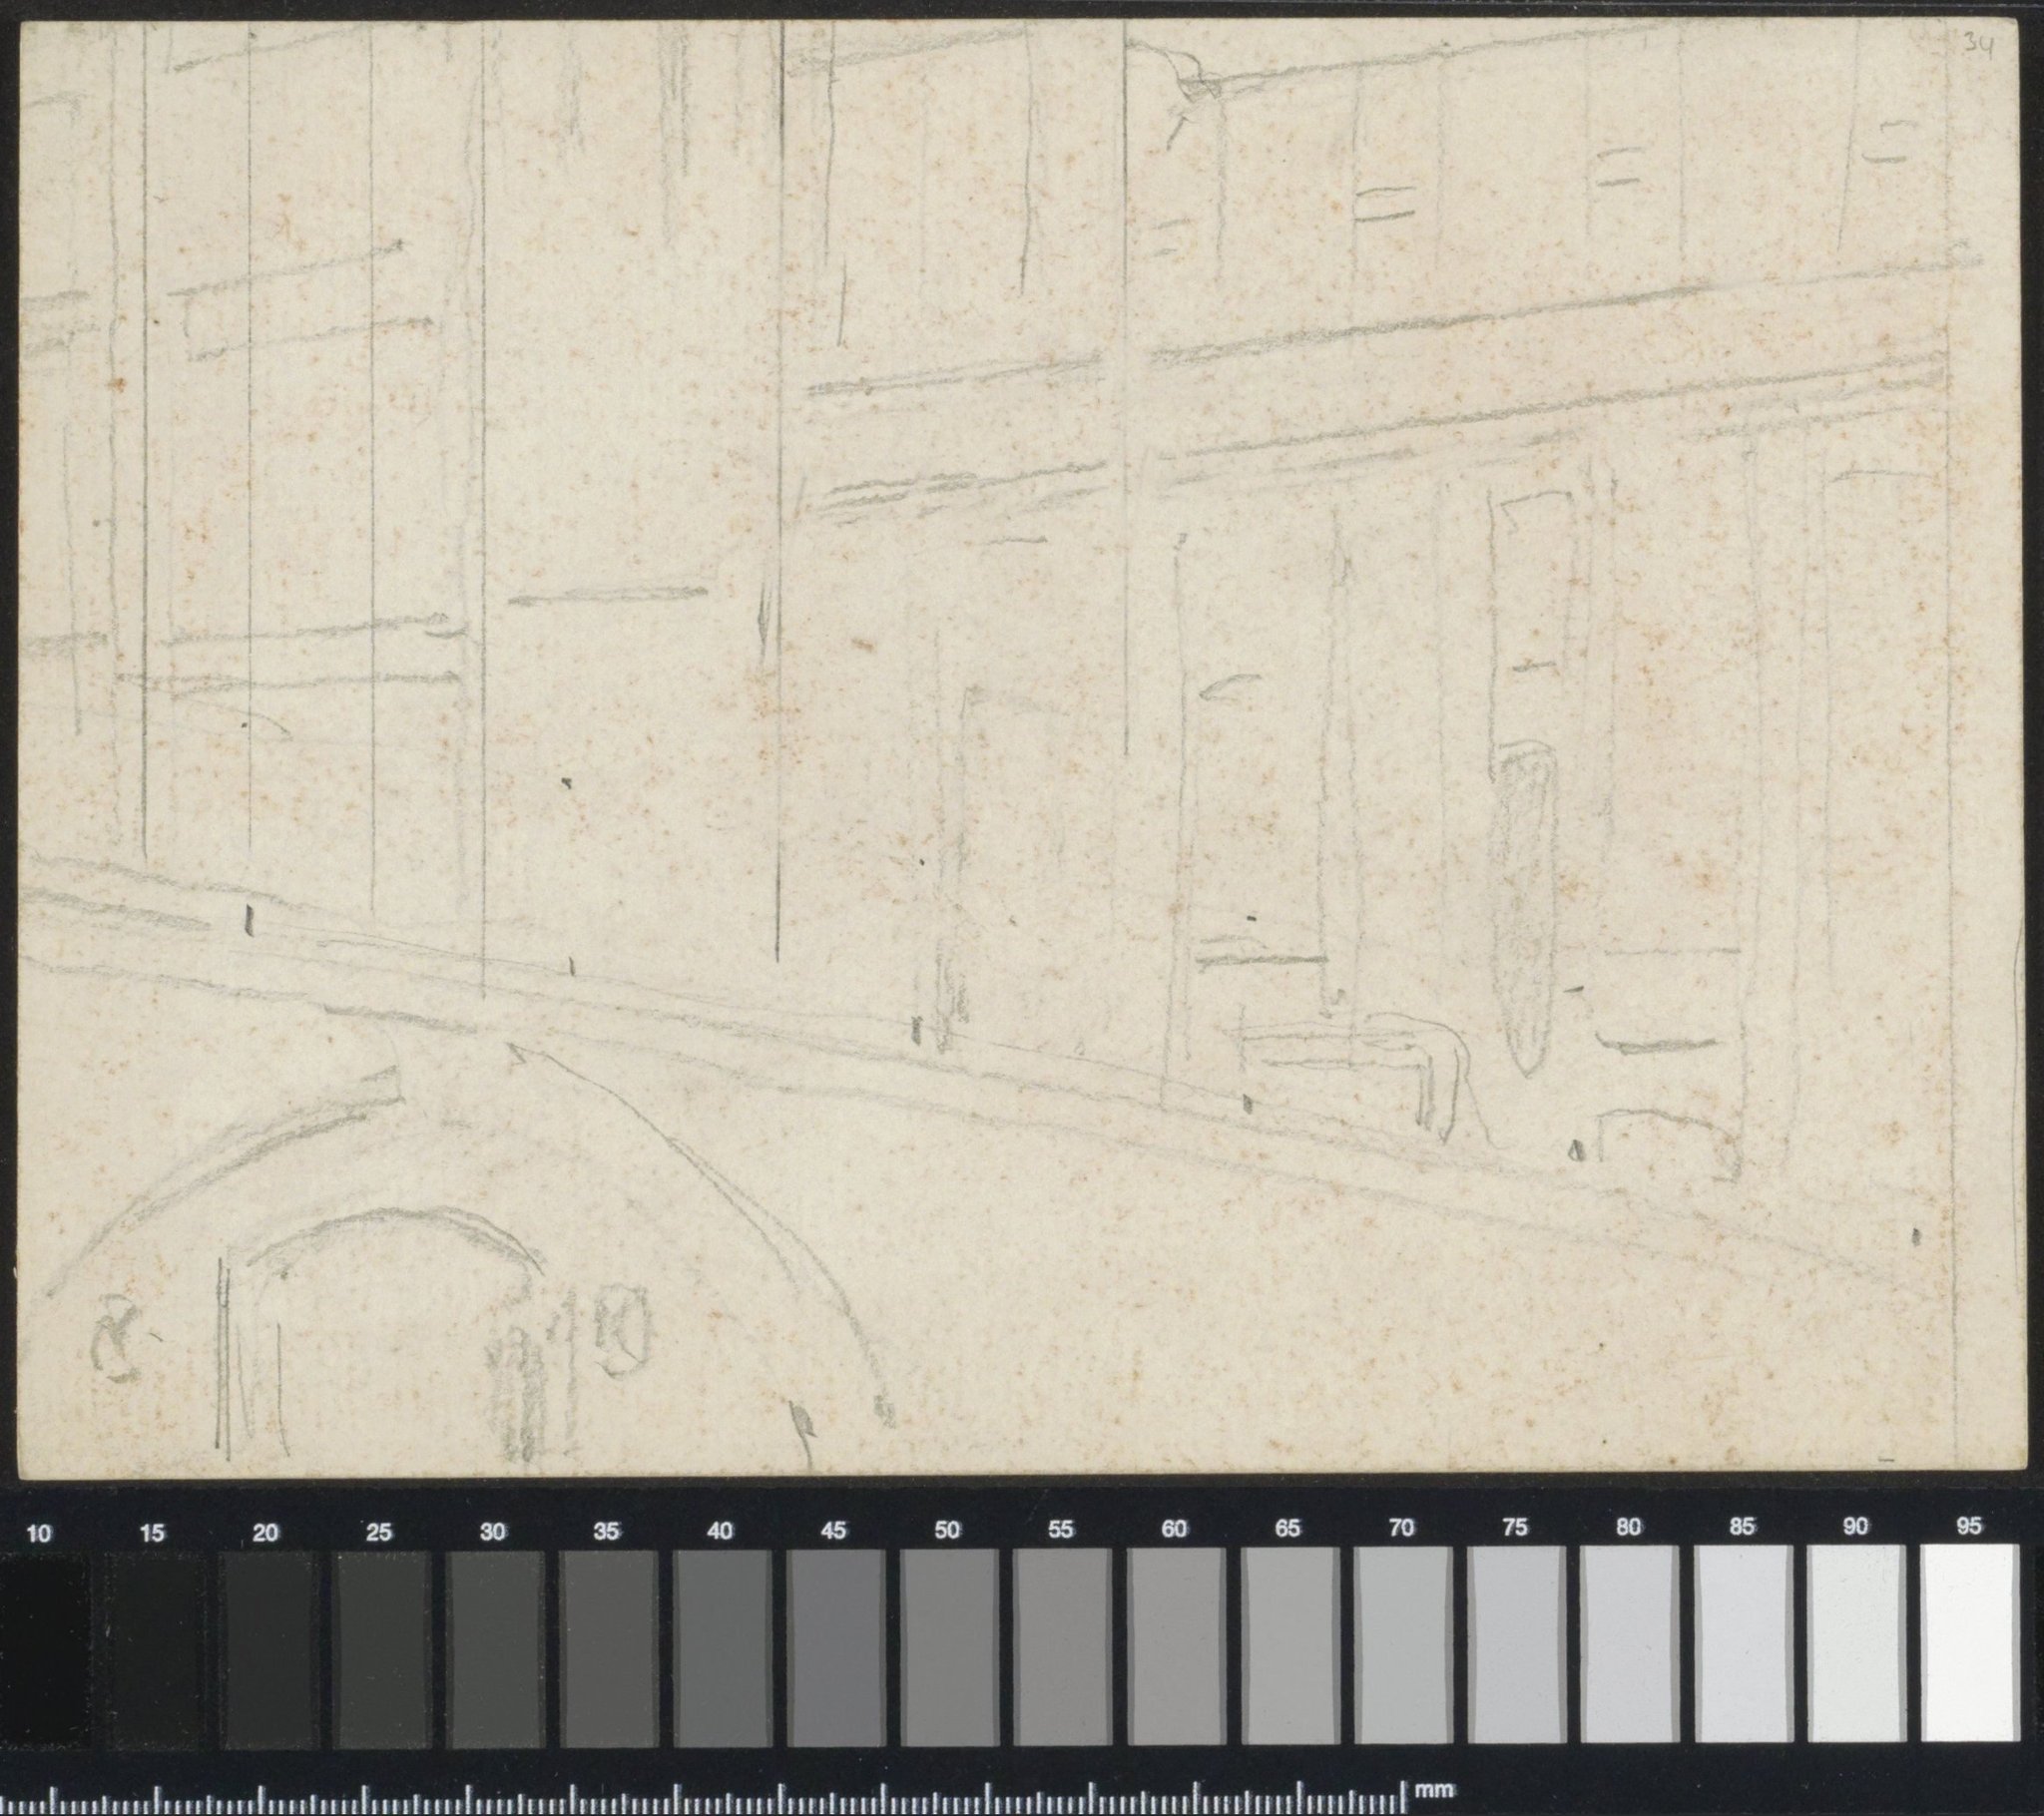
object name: sketchbook leaf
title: Architectuurstudies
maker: willem witsen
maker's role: draughtsman, painter, print maker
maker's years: 1860-1923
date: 1870-1923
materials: paper, pencil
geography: amsterdam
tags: civic architecture; edifices; dwellings